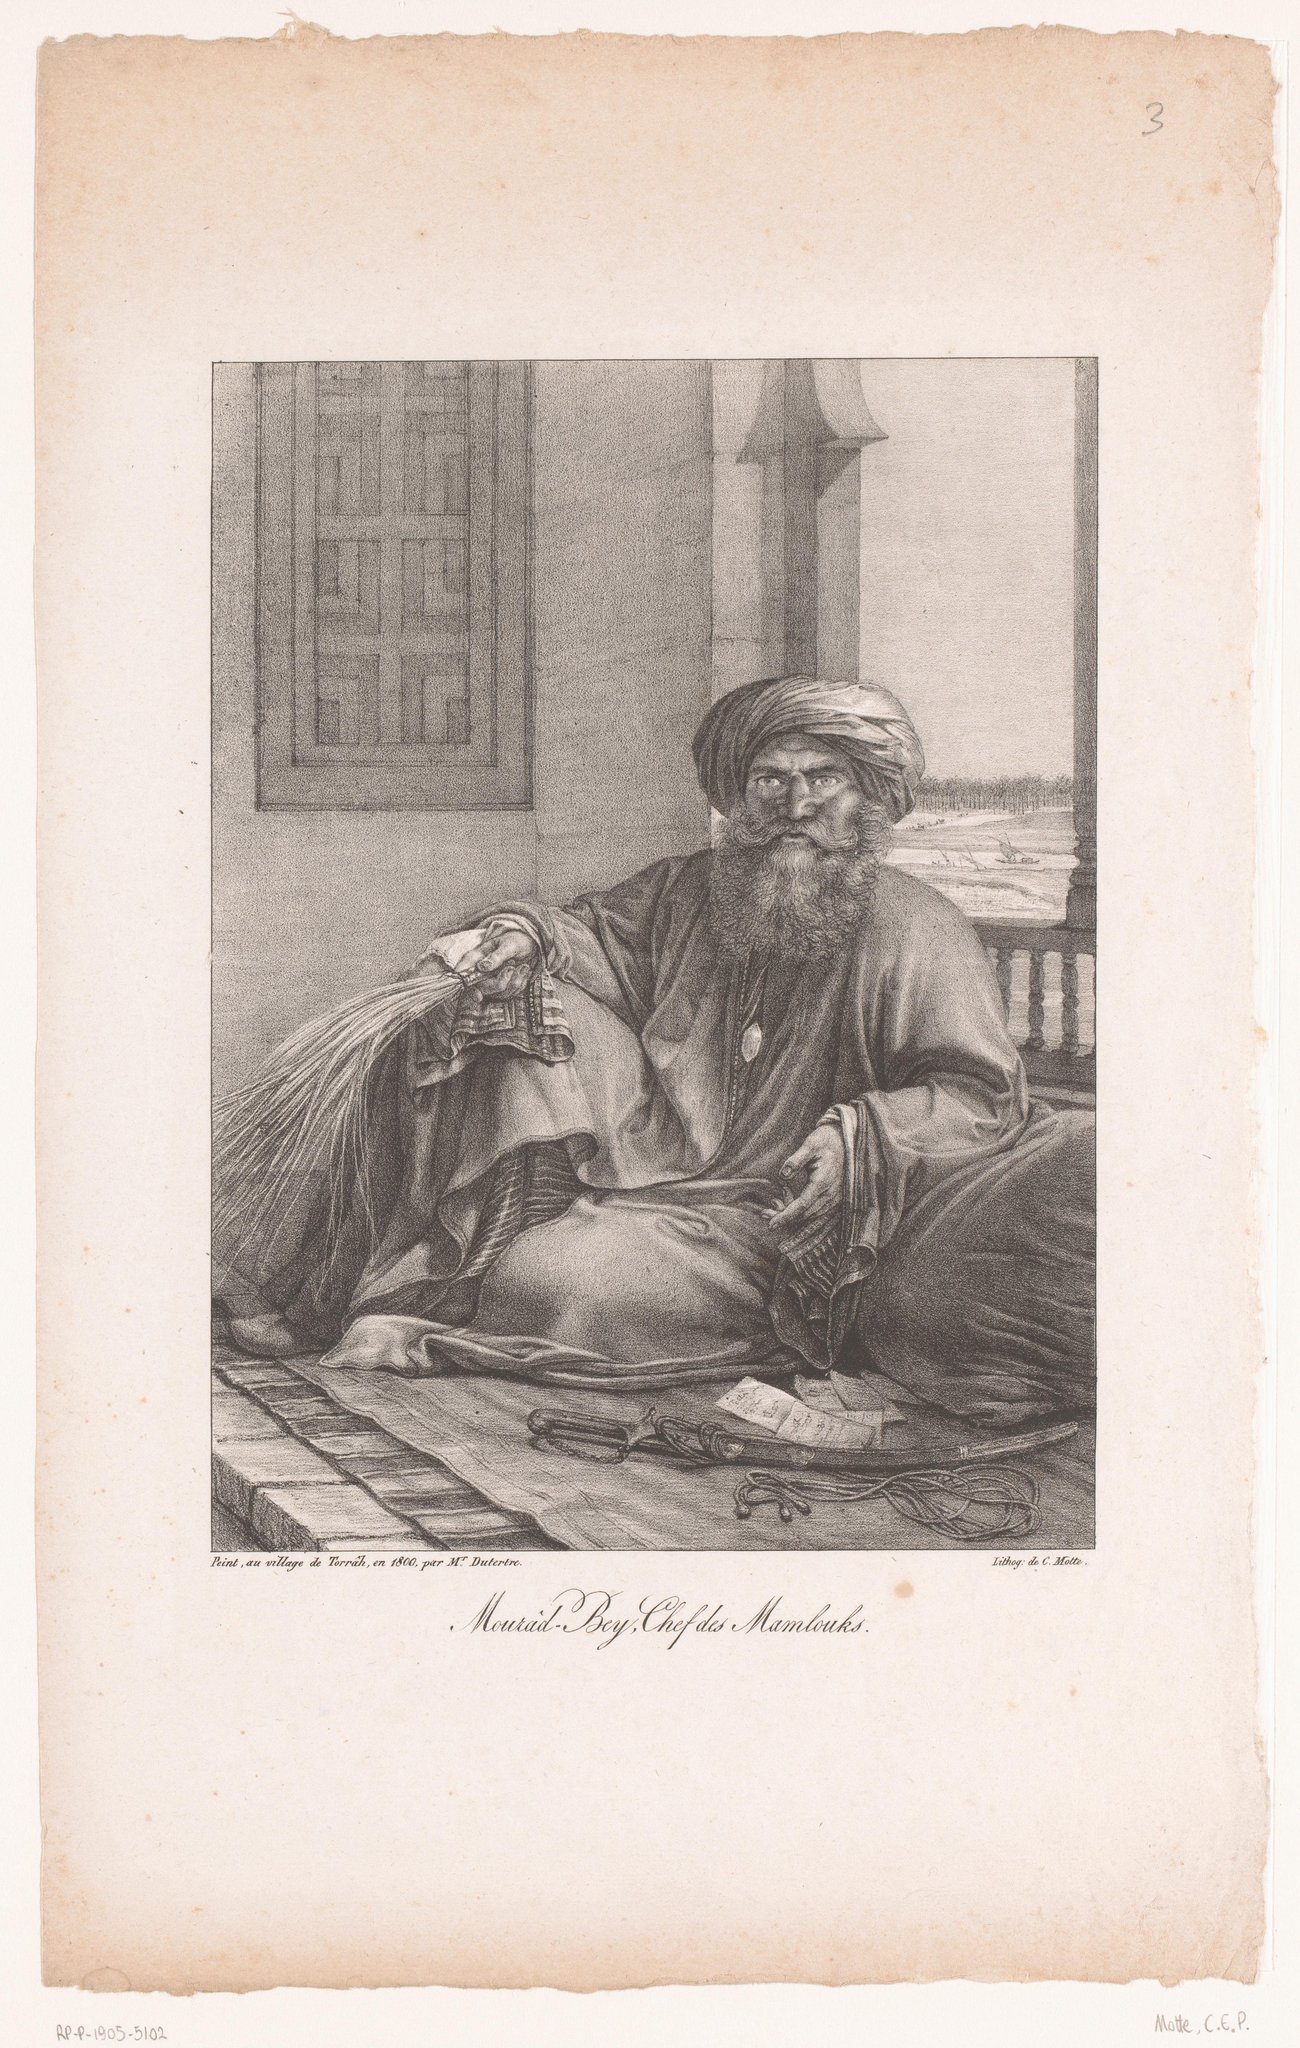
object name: print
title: Mourâd-Bey, chef des Mamlouks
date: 1817-1837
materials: paper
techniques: lithograph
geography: paris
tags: commander-in-chief, general, marshal, historical persons, slavery; serfs and enslaved persons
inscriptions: collector's mark: Lugt 2228